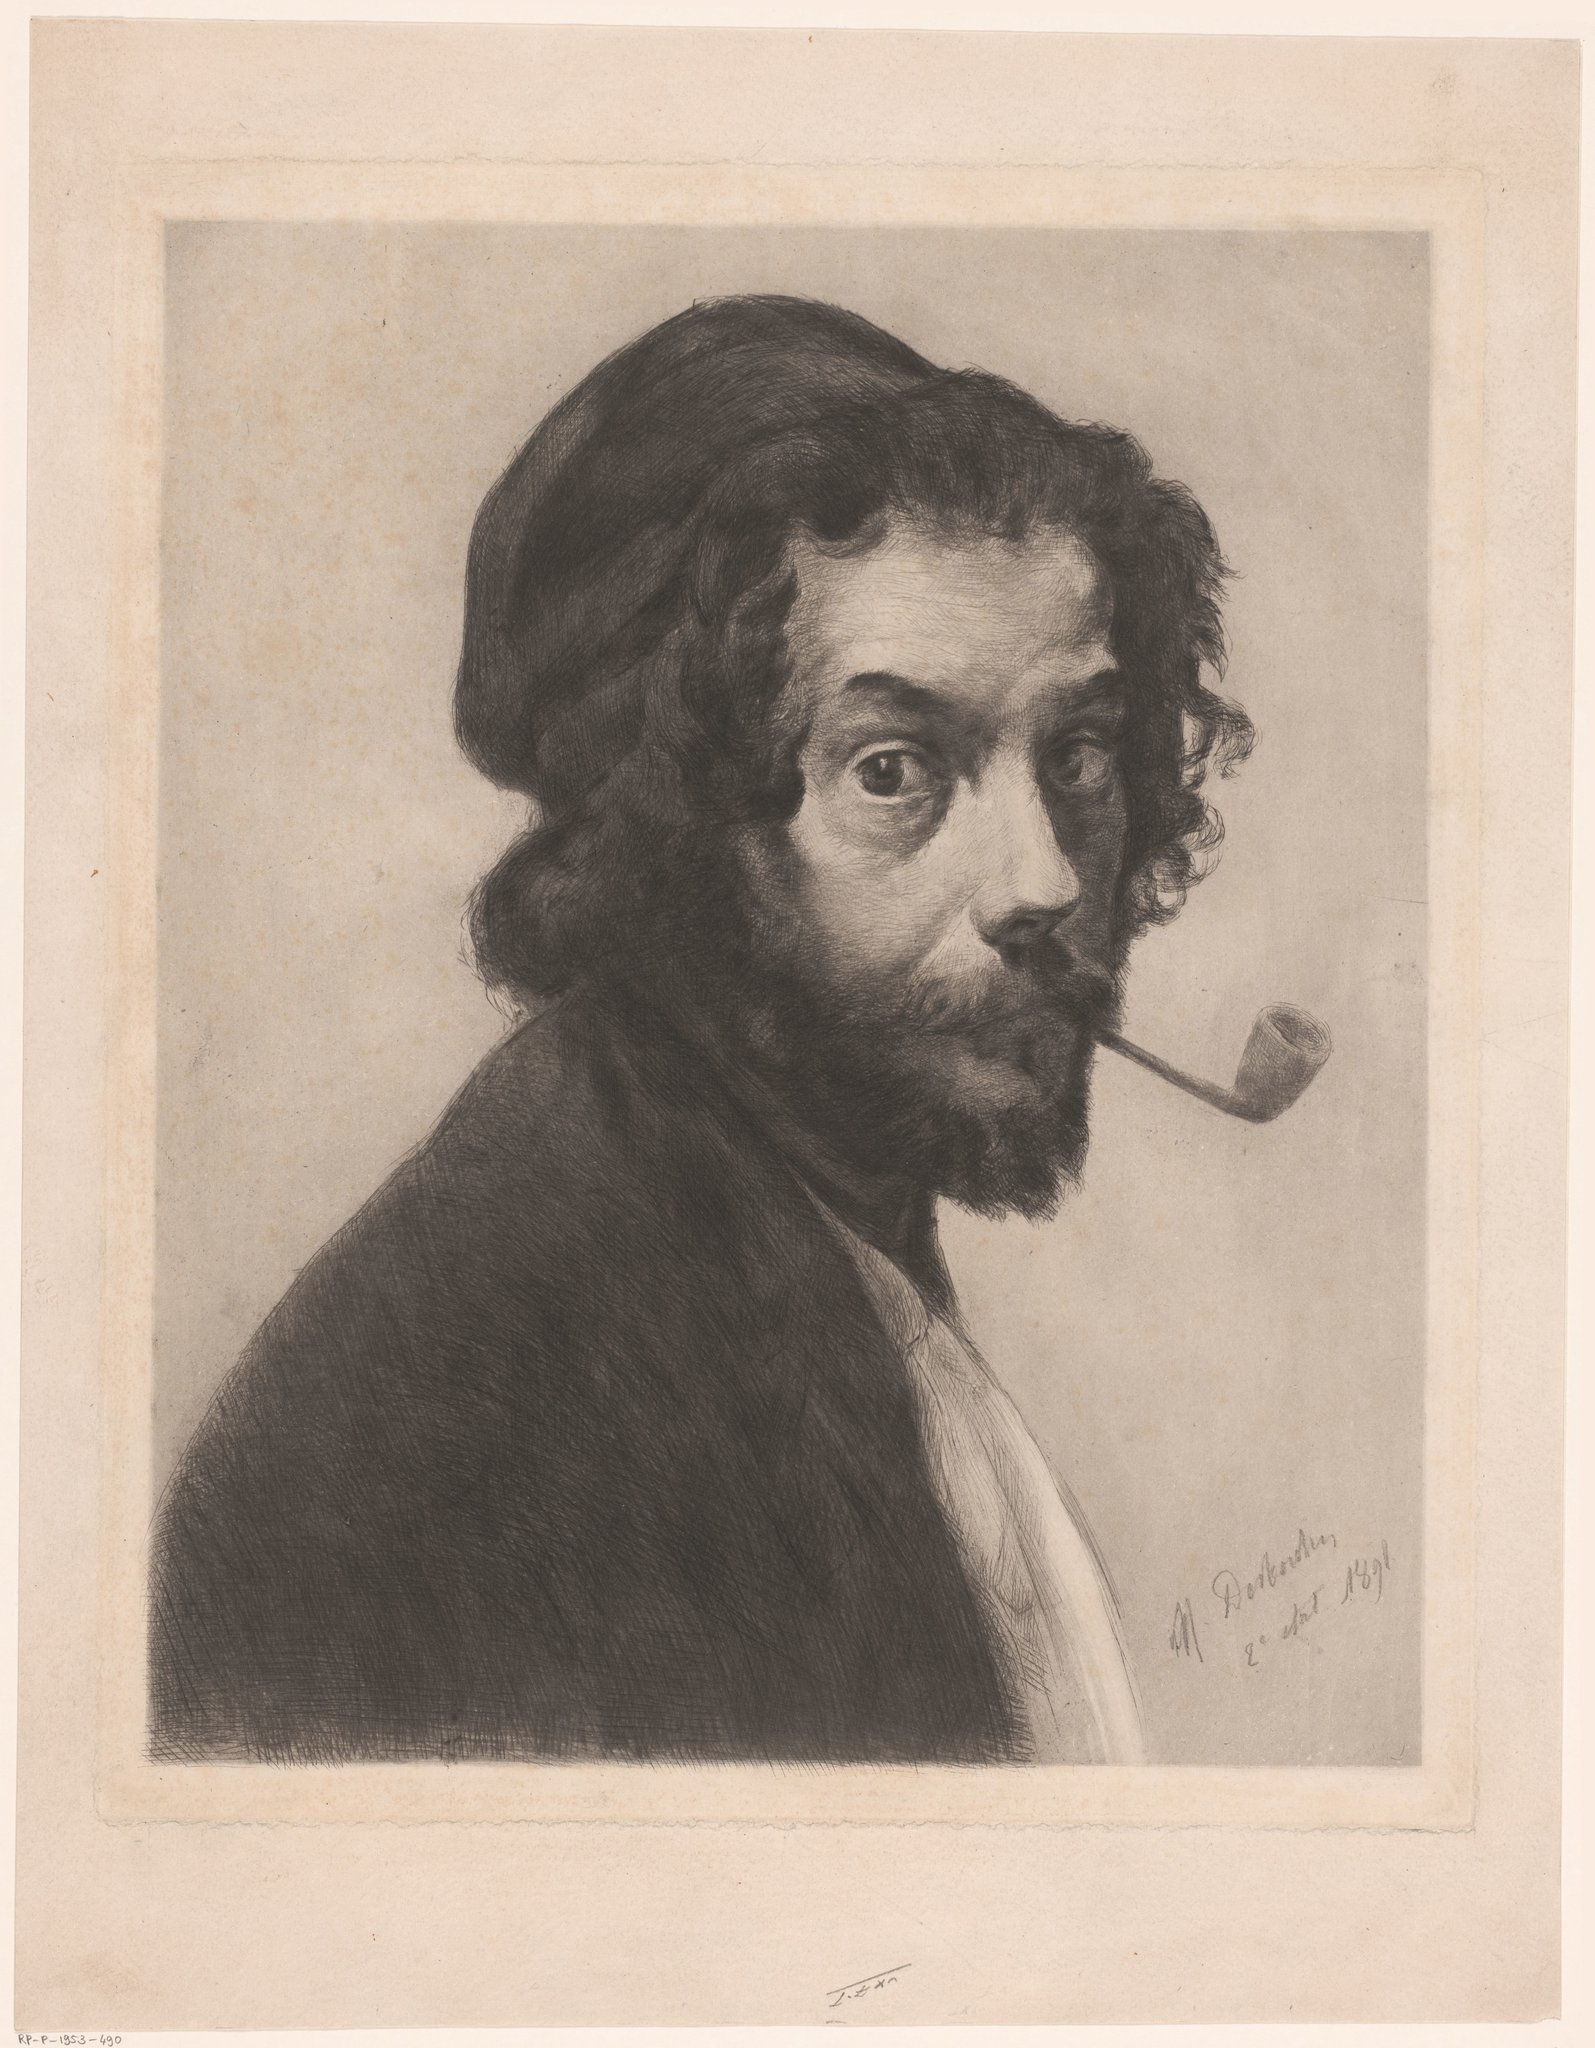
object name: print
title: Zelfportret met pijp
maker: marcellin gilbert desboutin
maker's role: print maker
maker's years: 1823-1902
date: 1898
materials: paper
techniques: drypoint, intaglio, roulette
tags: paris, print maker, marcellin gilbert desboutin, historical persons, pipe ~ tobacco, portrait, self-portrait of artist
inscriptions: collector's mark: Lugt 2760, collector's mark: Lugt 2228